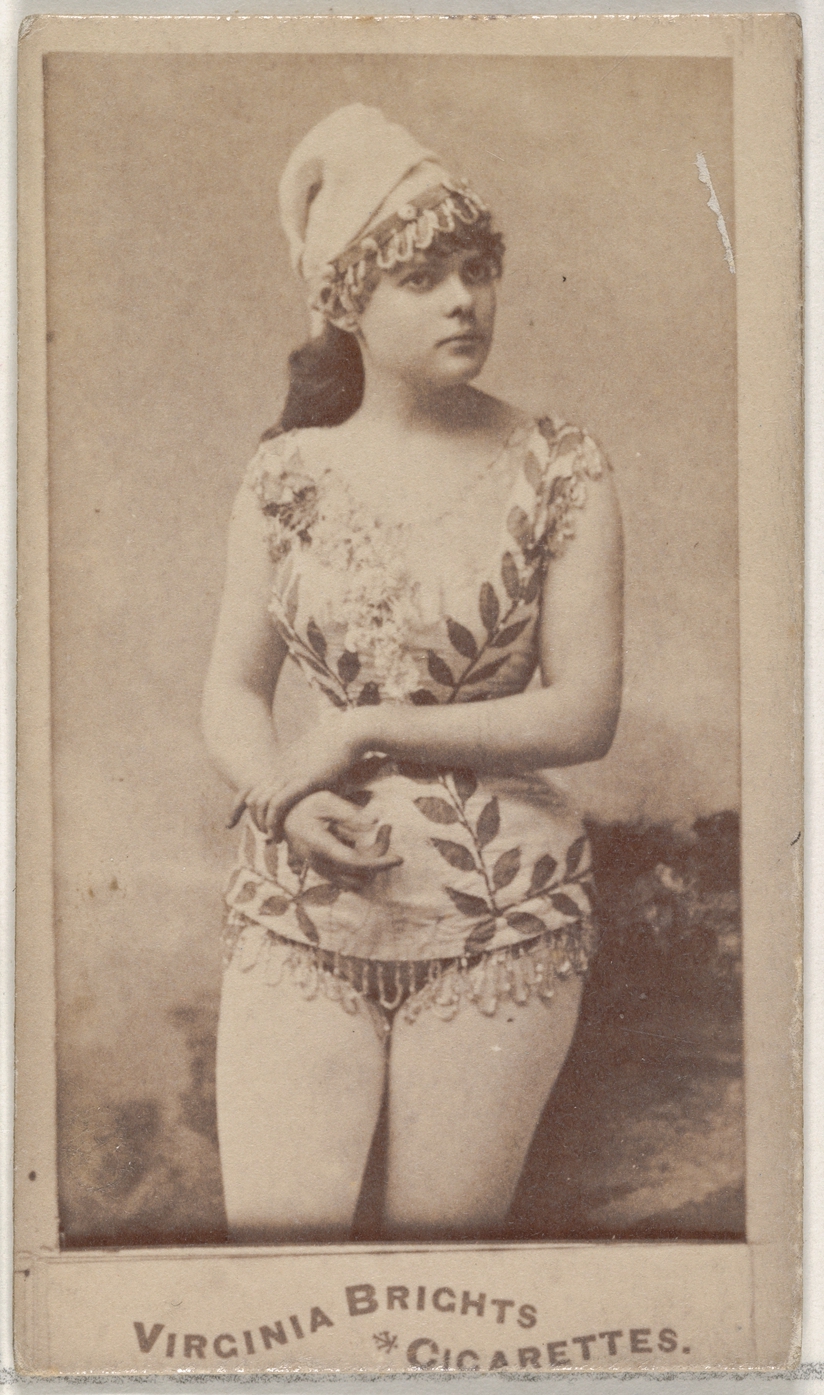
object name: photograph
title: From the Actors and Actresses series (N45, Type 5) for Virginia Brights Cigarettes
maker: allen & ginter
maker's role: publisher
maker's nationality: american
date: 1888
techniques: albumen silver print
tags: portraits,women,actresses